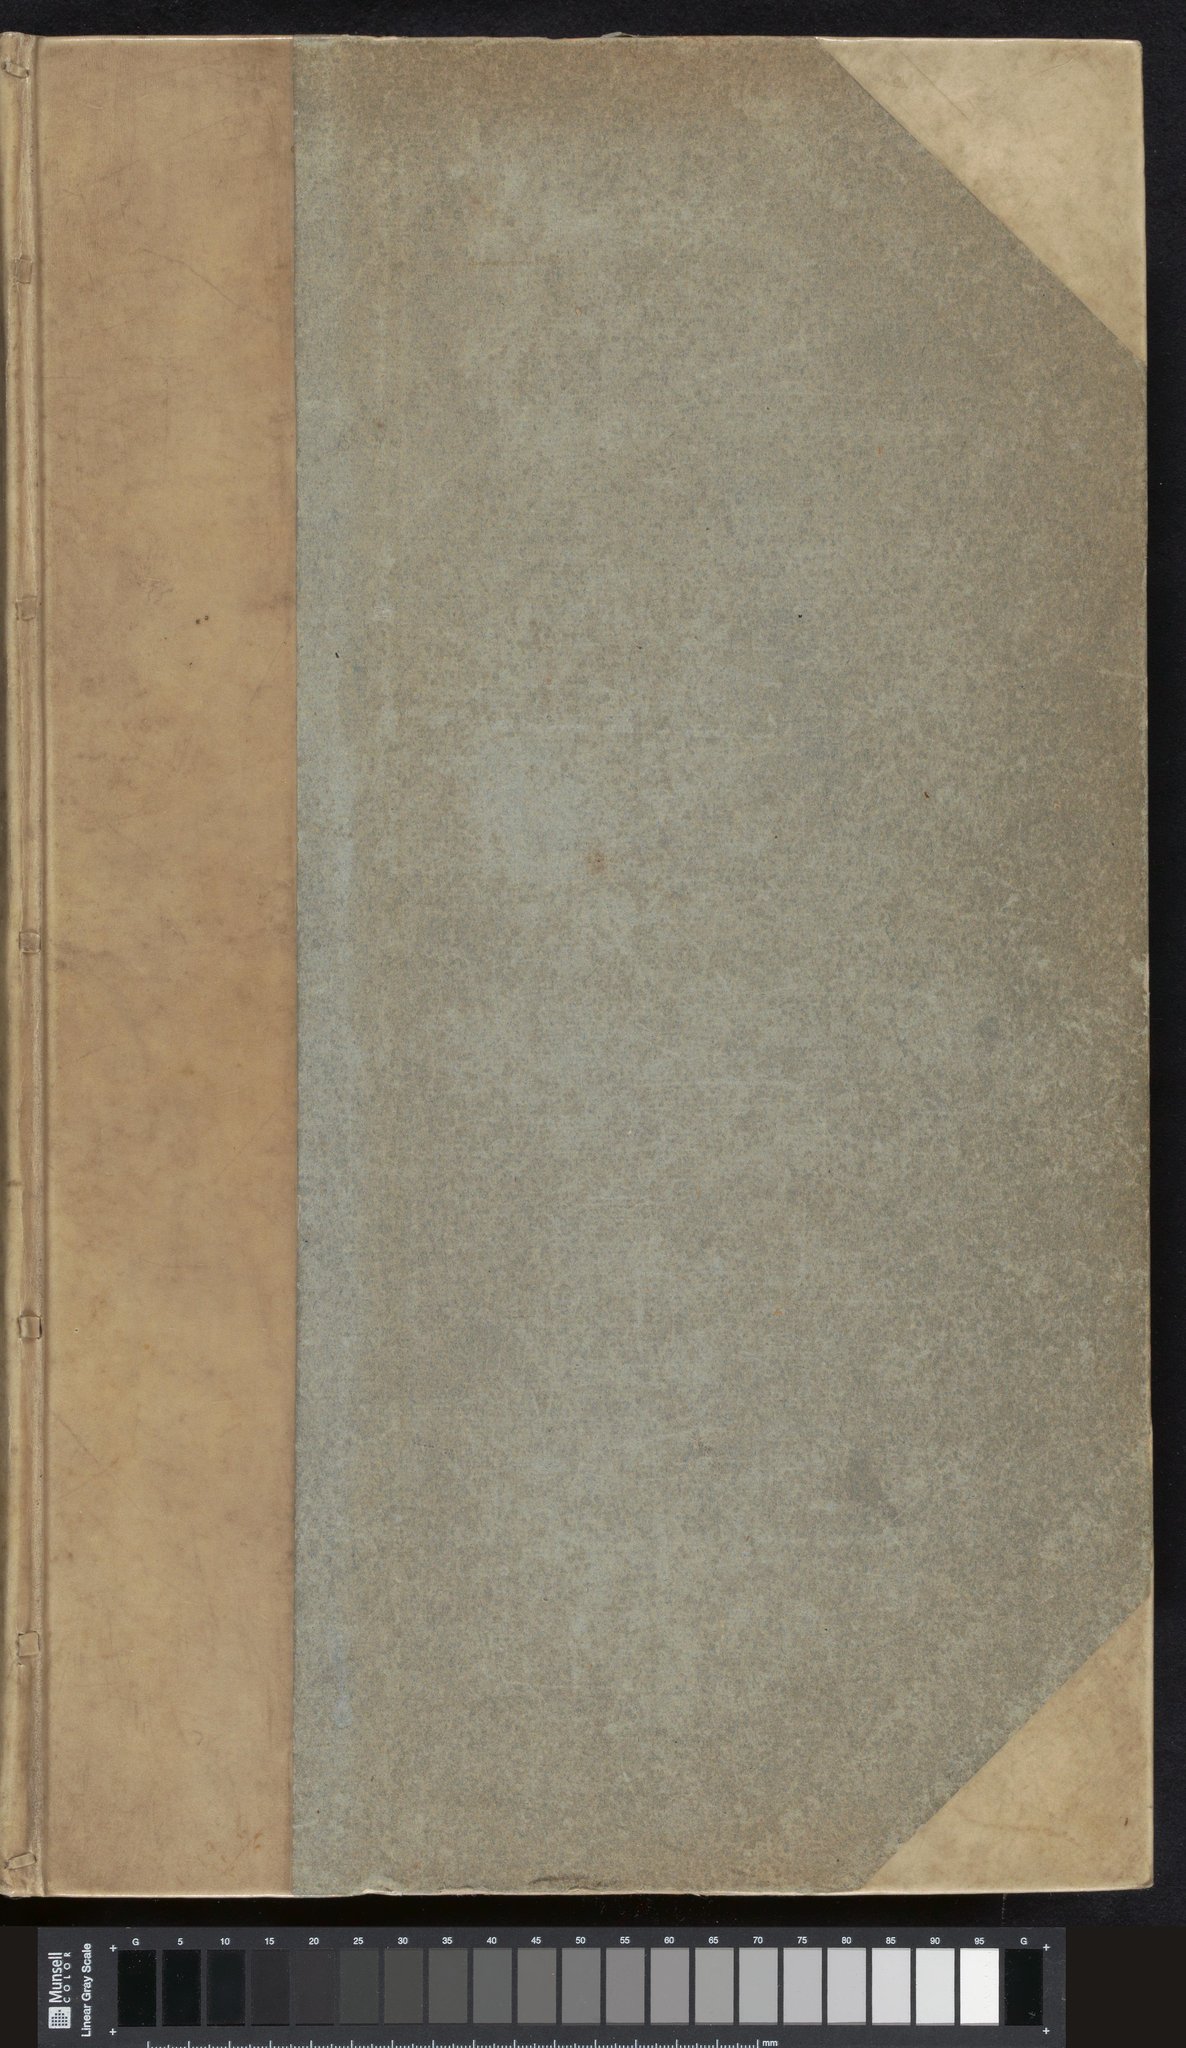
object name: book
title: Caspar Barlaeus, Rerum per octennium in Brasilia et alibi nuper gestarum sub praefectura J. Mauritii, Nassoviae, 1647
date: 1647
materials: paper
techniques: printing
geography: northern netherlands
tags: earl, johan maurits graaf van nassau-siegen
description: Het boek van Caspar Barlaeus getiteld: Rerum per octennium in Brasilia et alibi nuper gestarum sub praefectura J. Mauritii, Nassoviae, 1647. Het boek bevat 55 voorstellingen van de tocht naar en het verblijf in Brazilië van graaf Johan Maurits van Nassau in de jaren 1636-1644.